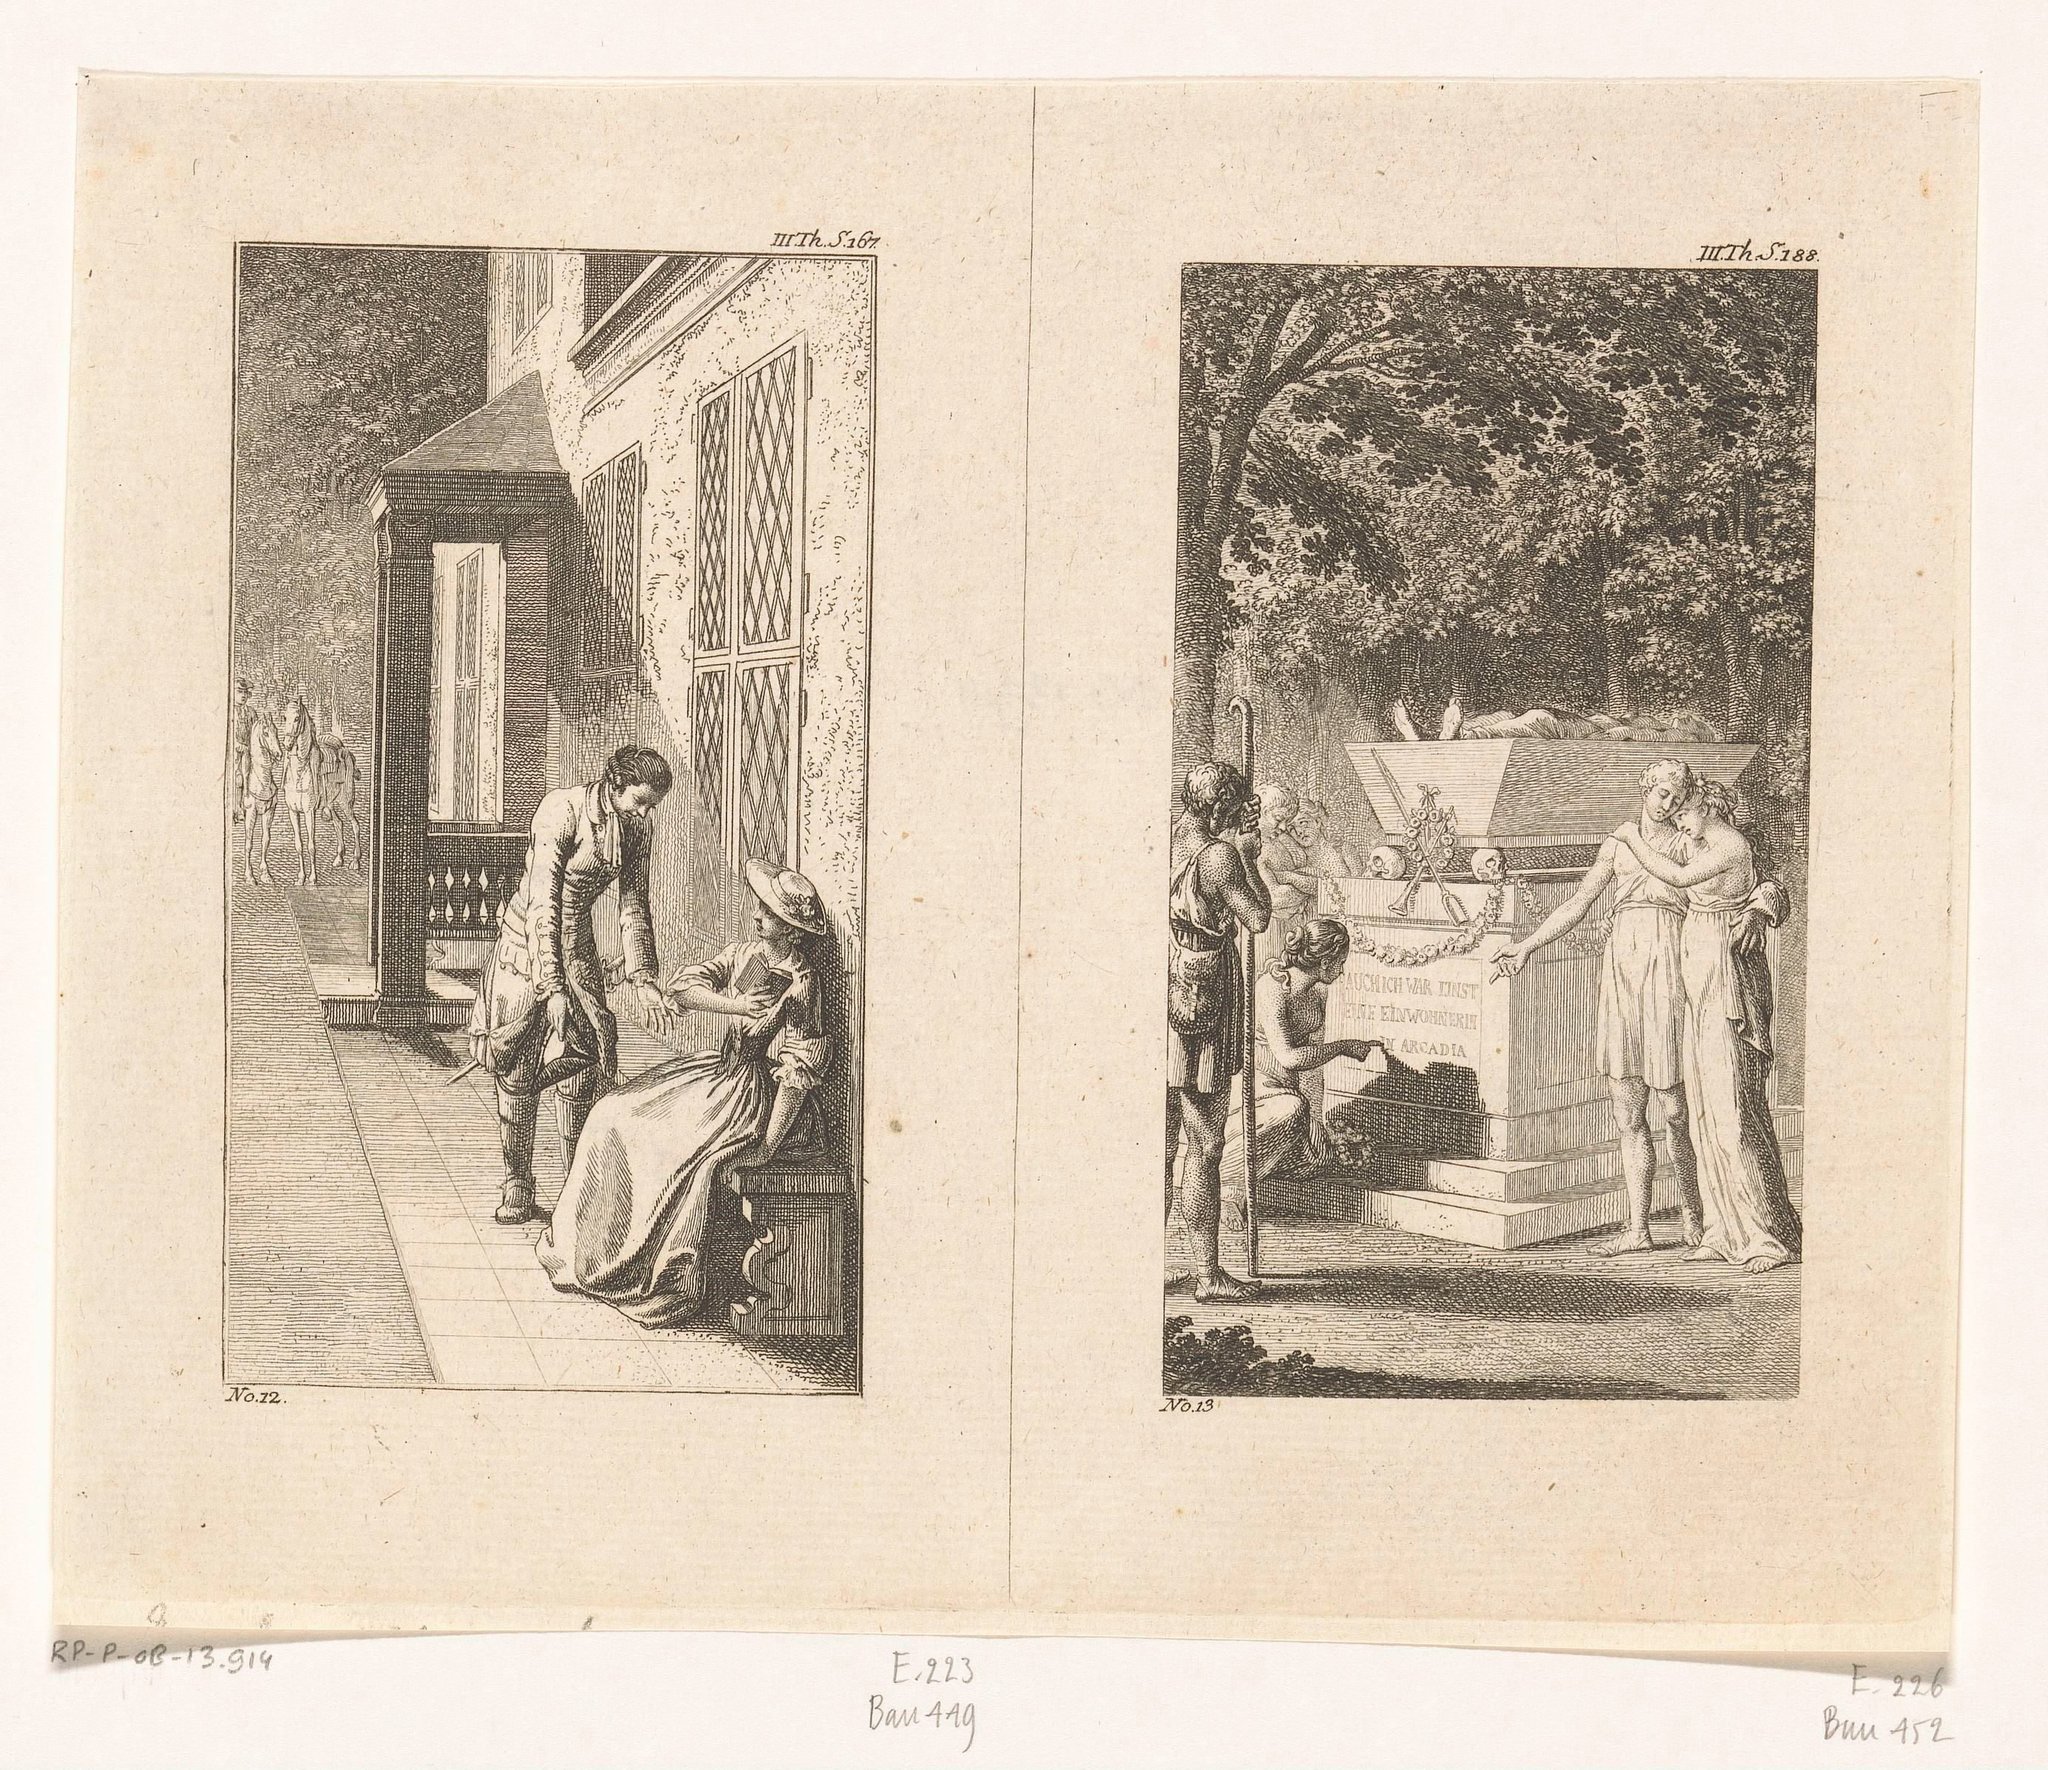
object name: print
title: Twee scènes uit Leben, Bemerkungen und Meinungen Johann Bunkels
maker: daniel nikolaus chodowiecki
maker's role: draughtsman, print maker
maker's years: 1726-1801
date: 1778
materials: paper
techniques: etching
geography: berlin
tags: reading, literature, book - mm - book open, façade (of house or building), grave-building, monumental tomb, pastorals, arcadian scenes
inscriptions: collector's mark: Lugt 2228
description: Prenten ook gebruikt in: Leben, Bemerkungen und Meinungen Johann Bunkels, nebst den Leben verscheidener merkwürdiger Frauenzimmer. 4 dln. Berlijn: Friedrich Nicolai, 1778. De Engelse uitgave verscheen tussen 1756-1766 onder de titel 'The life of John Buncle' en wordt meestal toegeschreven aan Thomas Armory. Chodowiecki etste in totaal 16 scènes voor dit werk.